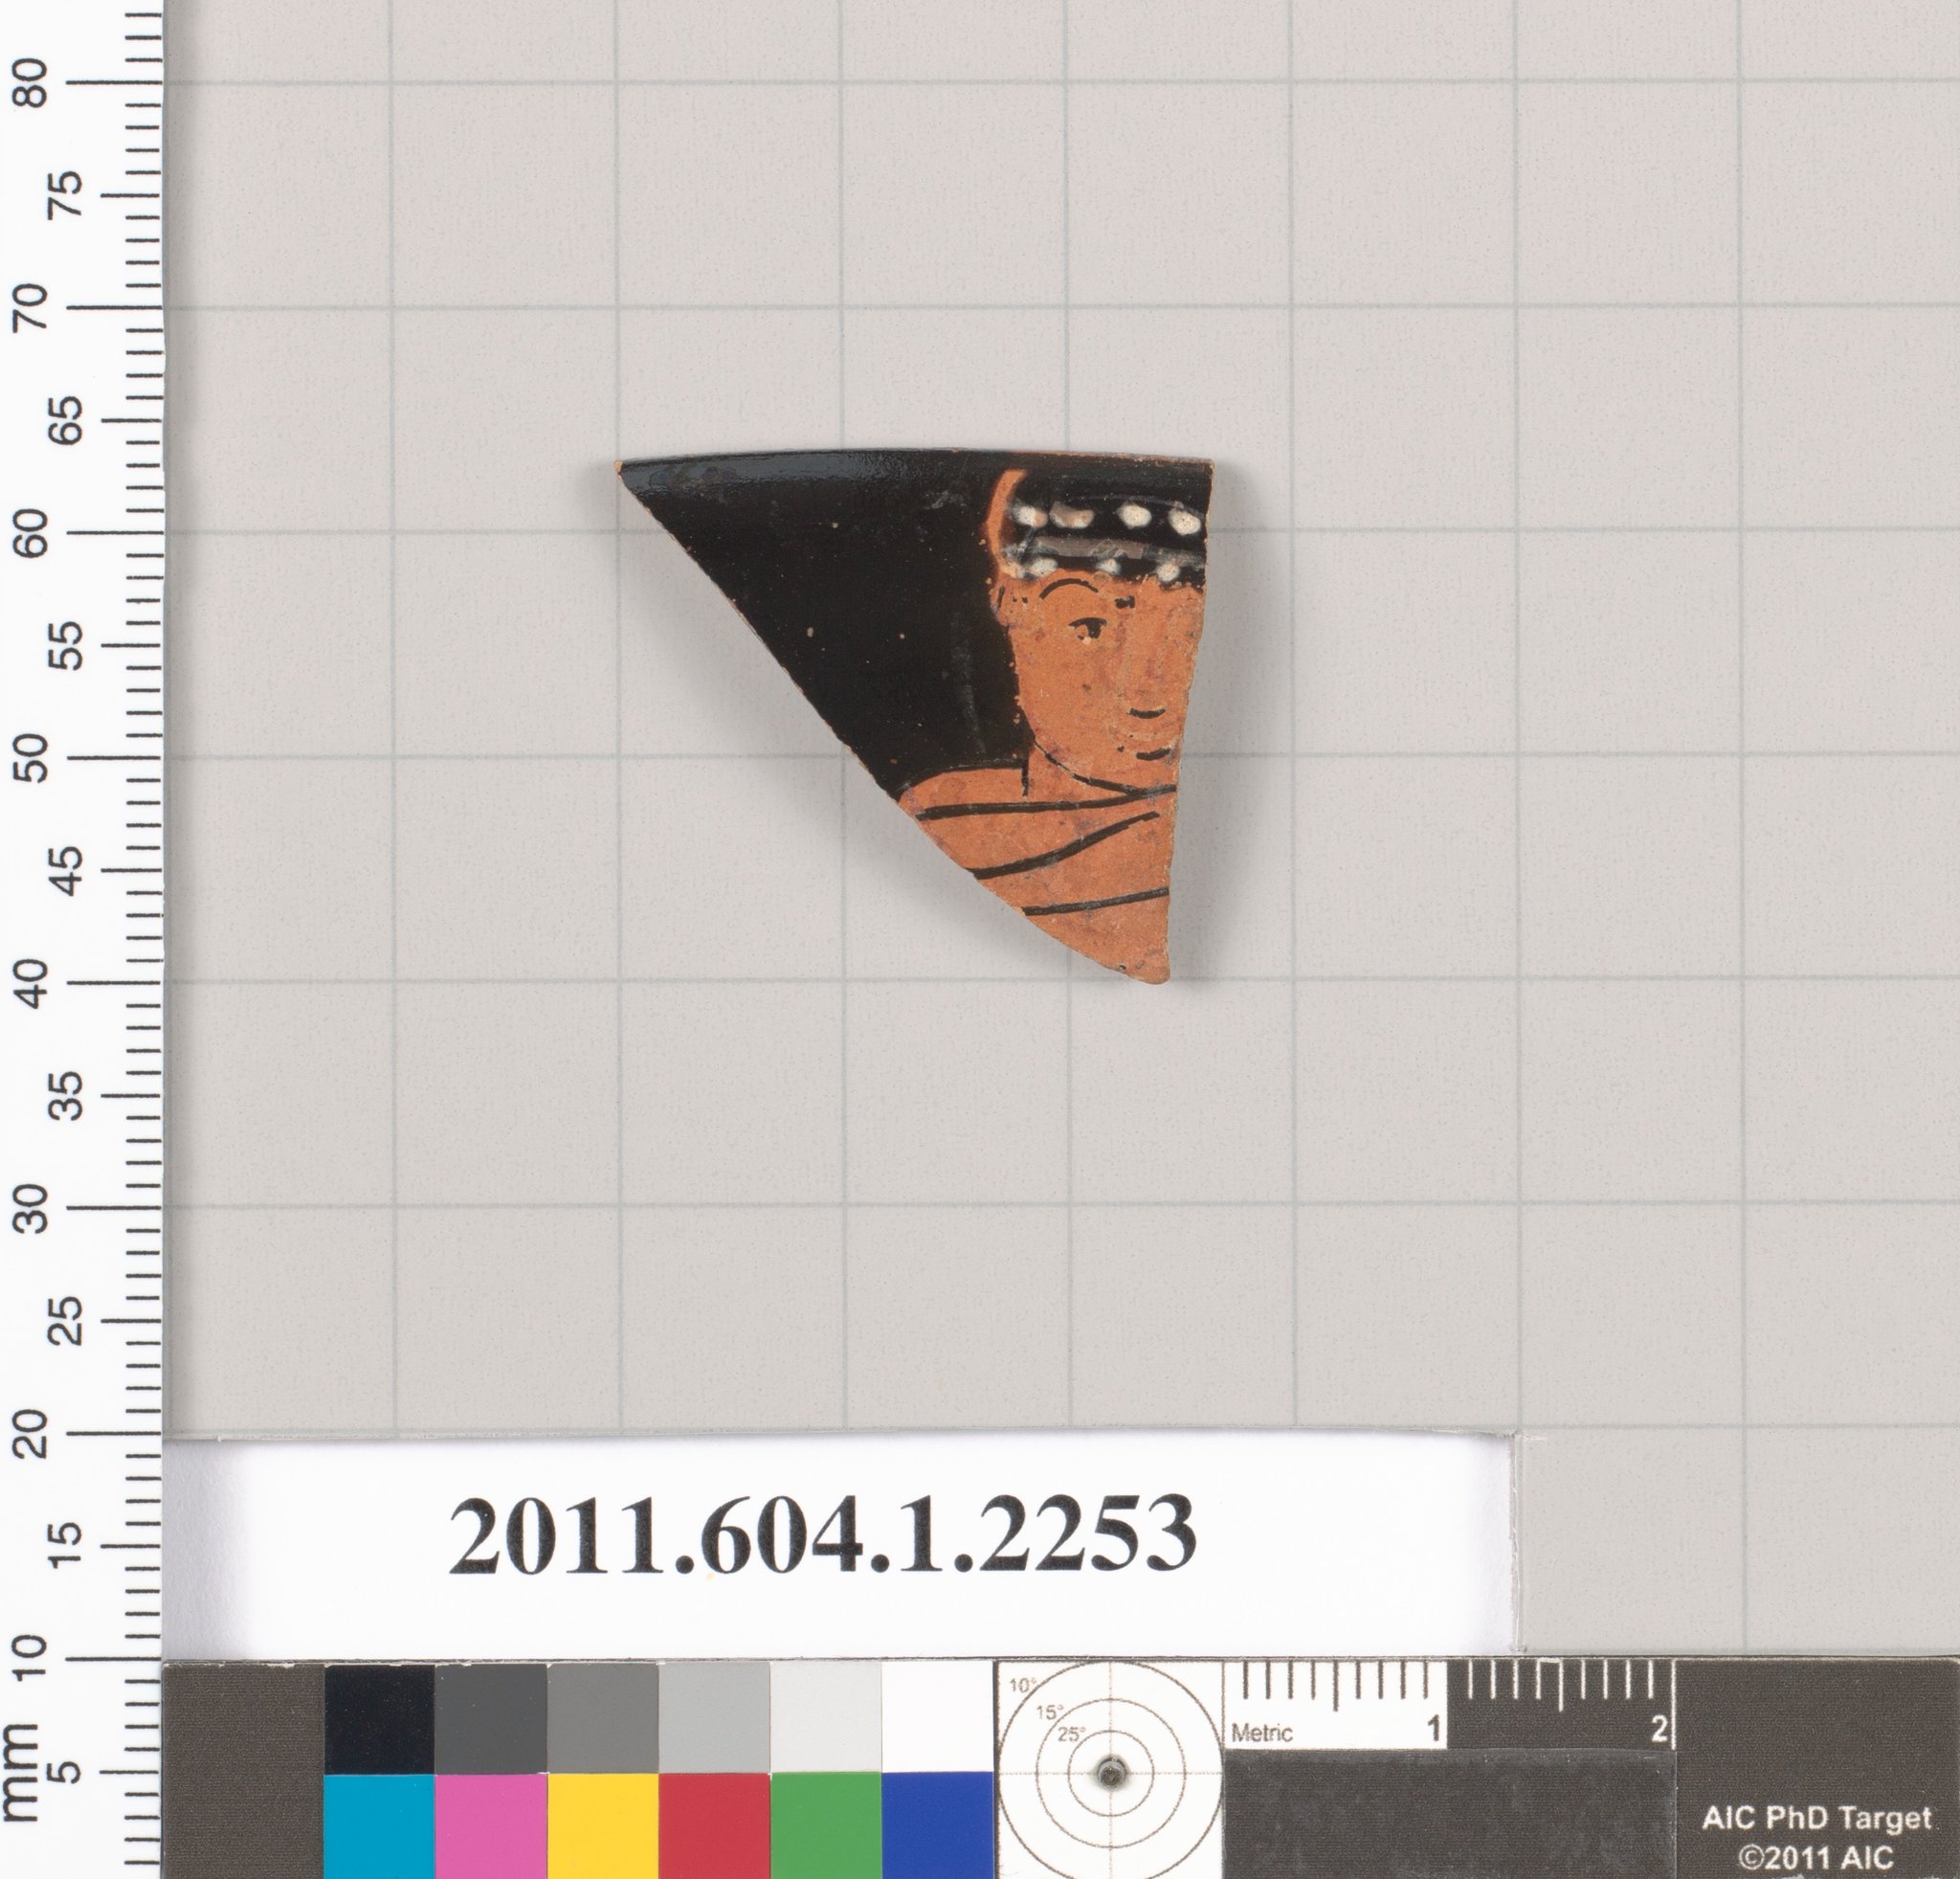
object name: kylix fragment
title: Terracotta rim fragment of a kylix (drinking cup)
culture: greek, attic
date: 467-435 BCE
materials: terracotta